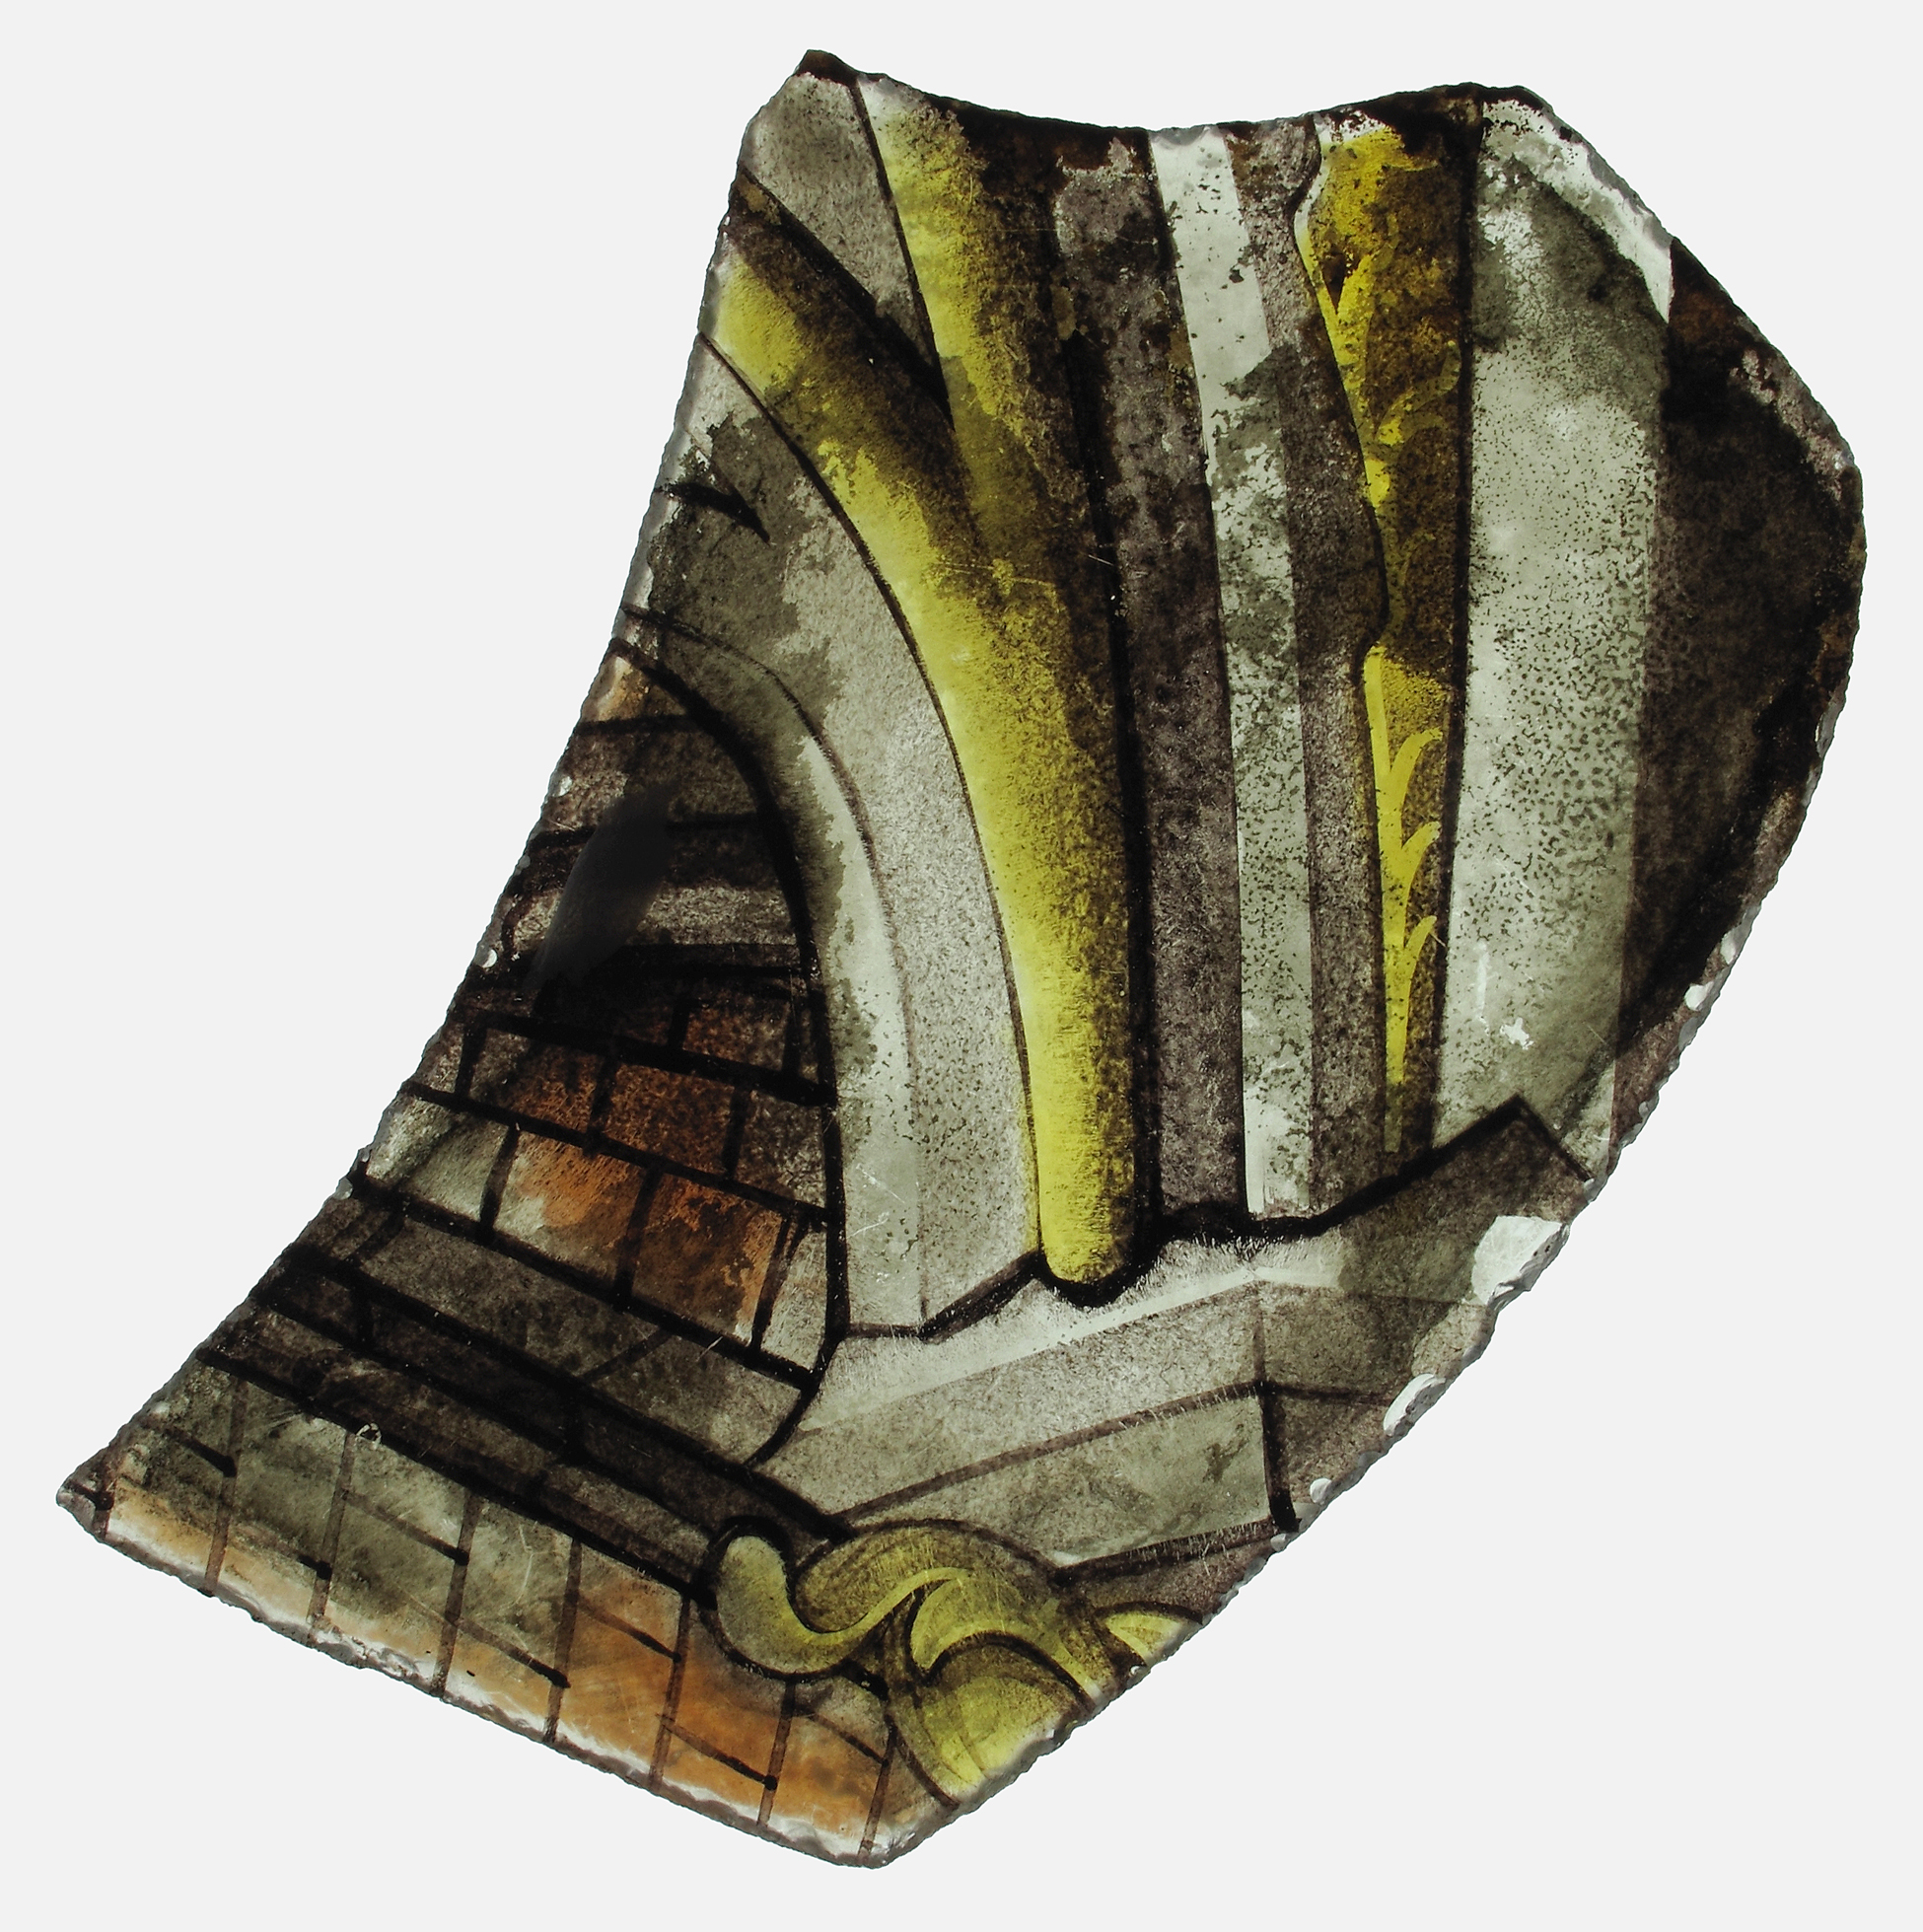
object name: fragment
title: Glass Fragment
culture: european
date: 1467-1500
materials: glass